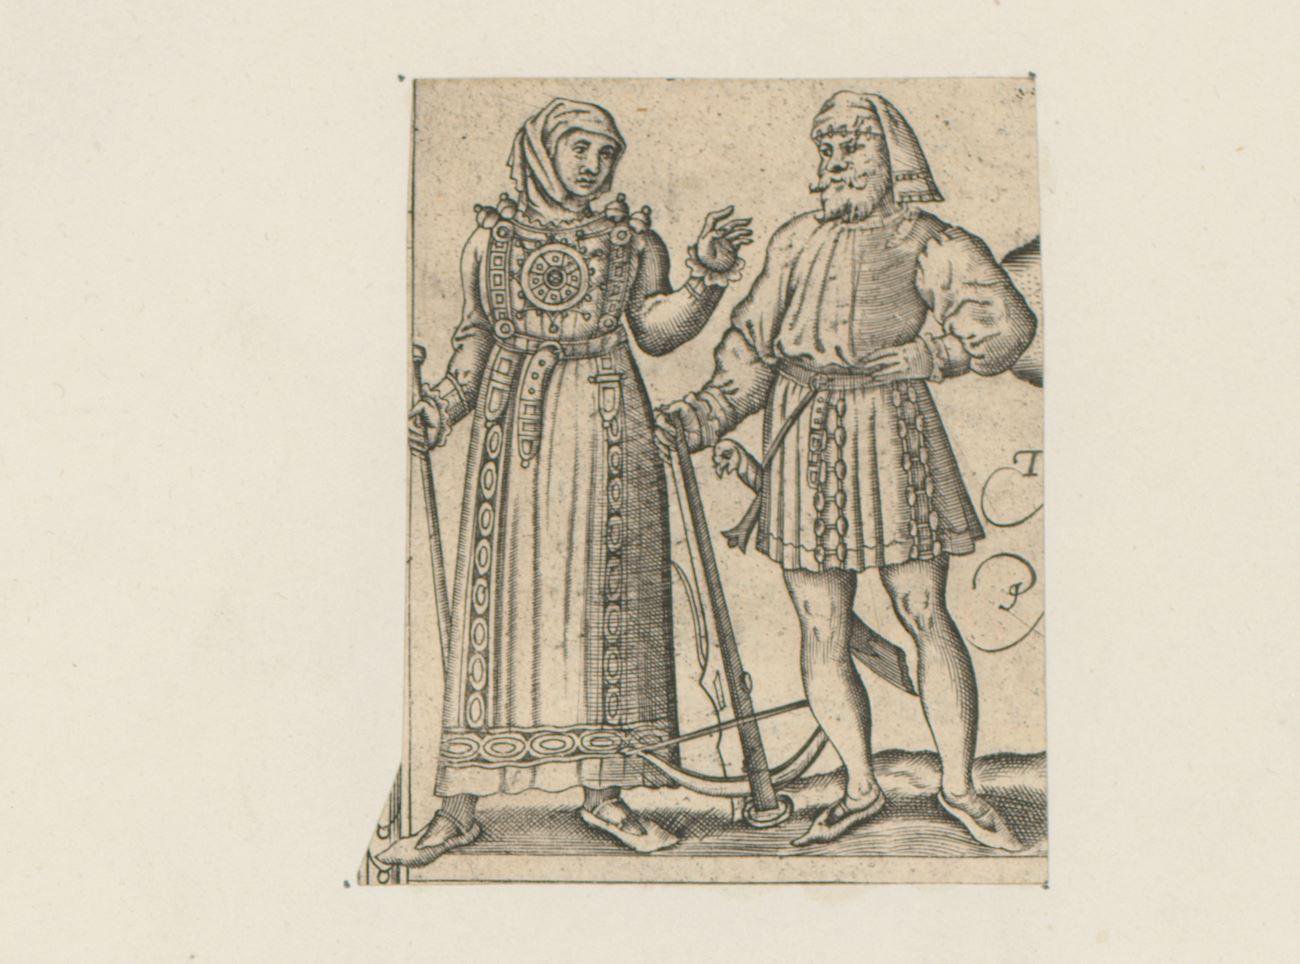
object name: ornament print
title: Ornament van een kaart van Friesland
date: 1592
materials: paper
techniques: engraving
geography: antwerp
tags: folk costume, regional costume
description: Man en vrouw in Friese klederdracht. Het ornament is een fragment van een kaart van Friesland. De prent maakt deel uit van een album.